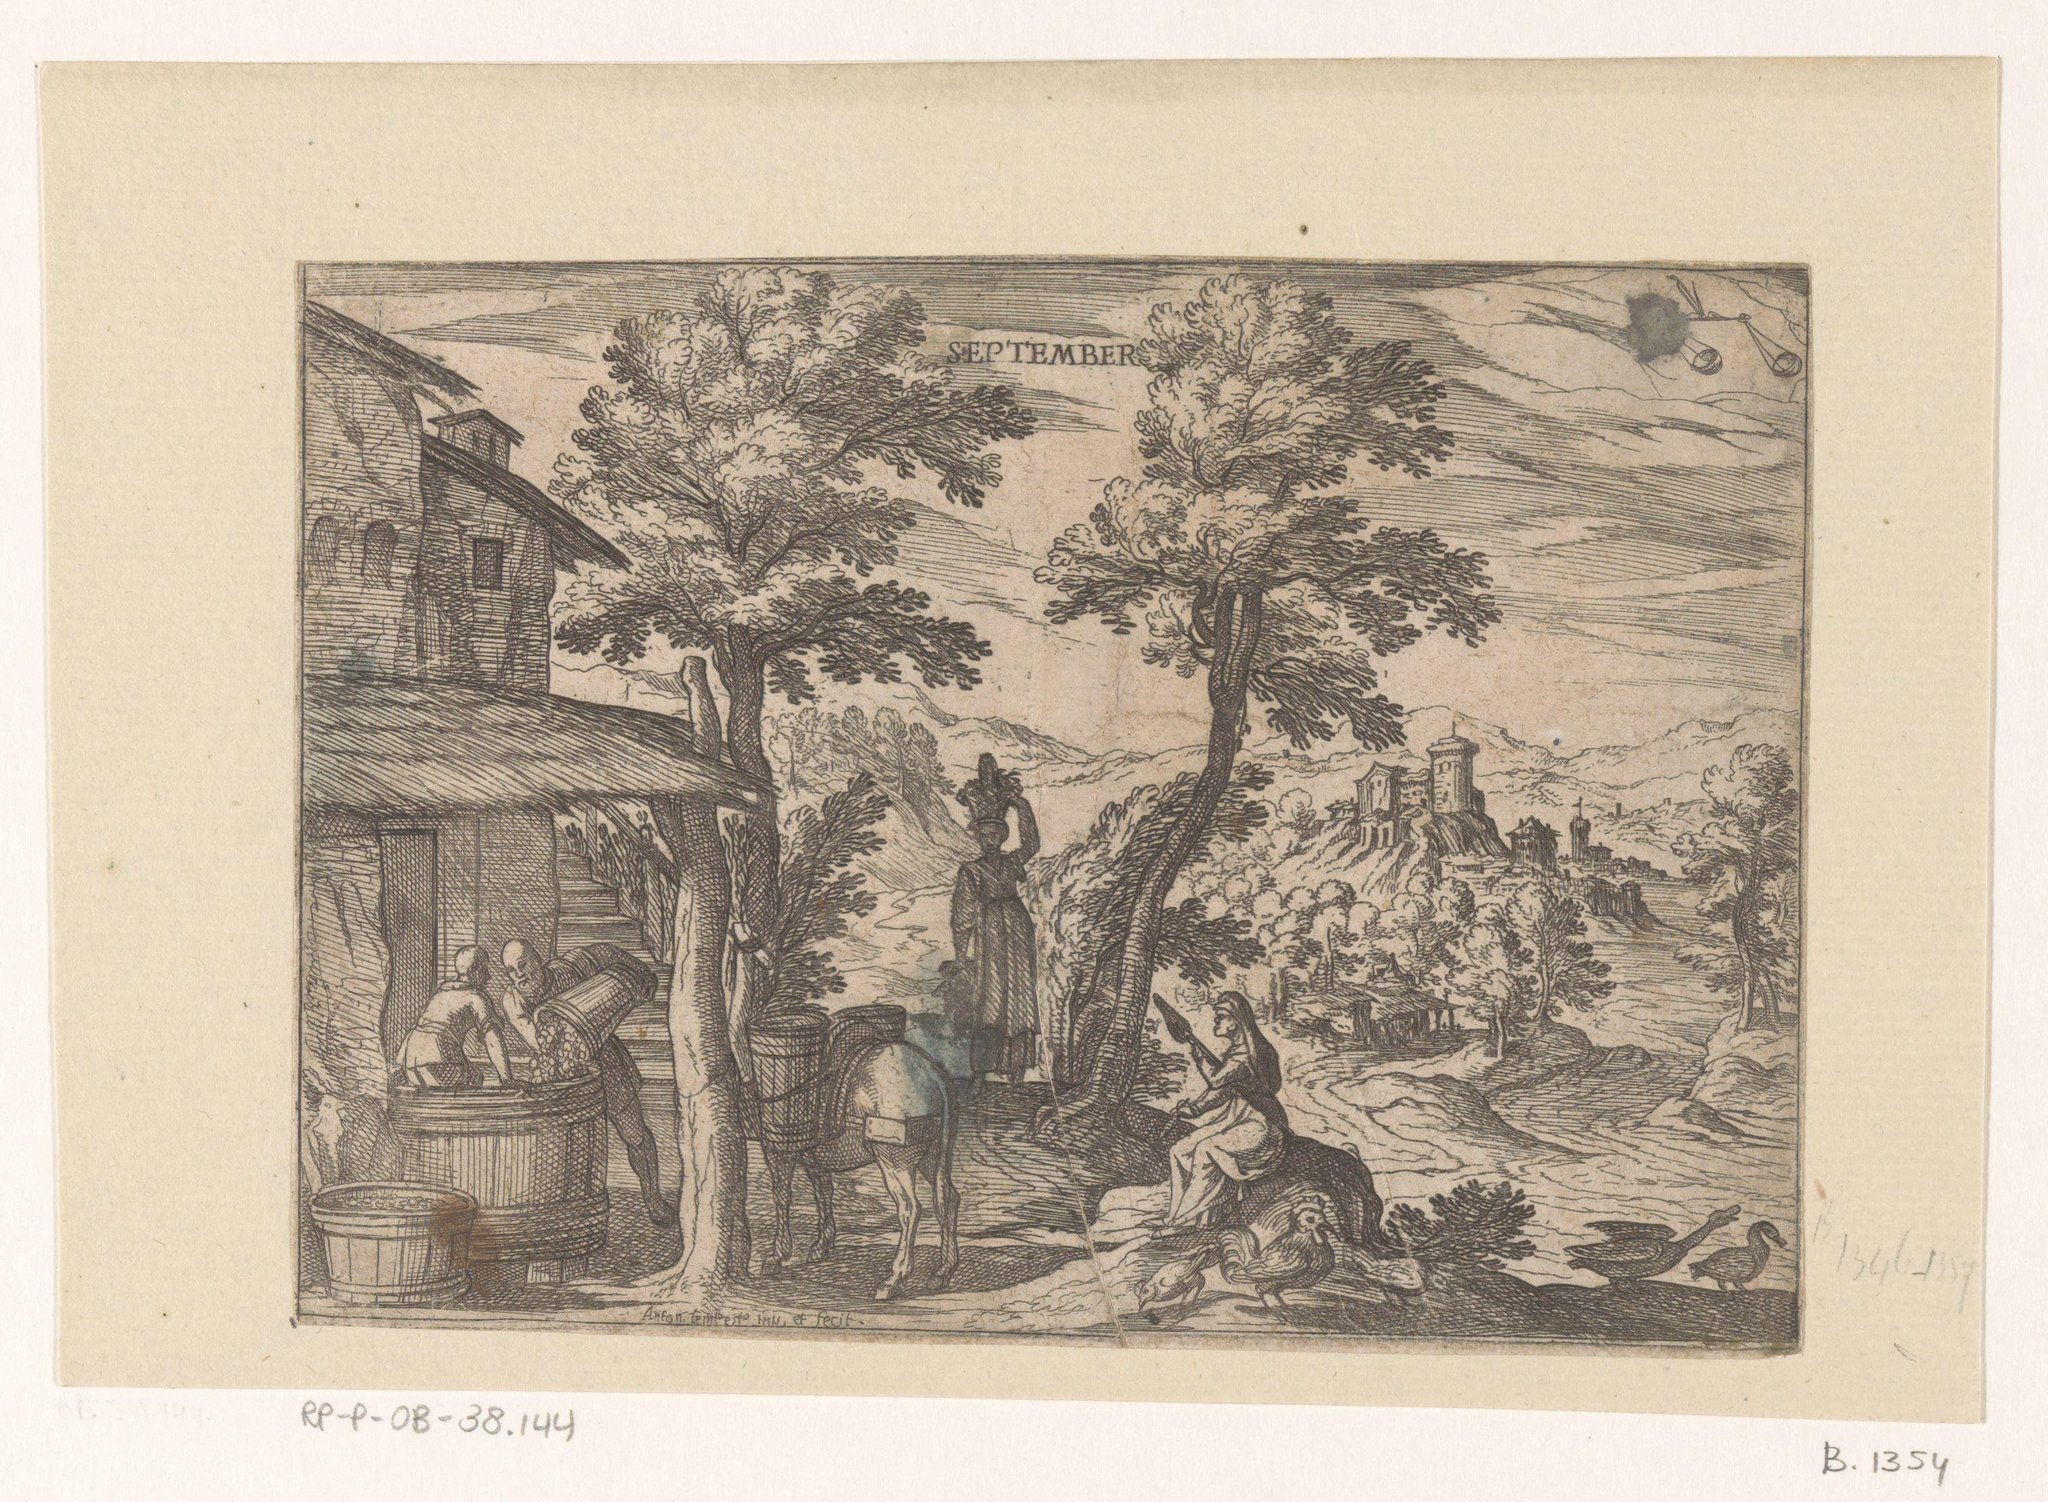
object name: print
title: September: wijn maken (weegschaal)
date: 1575-1613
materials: paper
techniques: etching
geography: italy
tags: landscape symbolizing september, wine production, spindle, libra (zodiacal sign of september)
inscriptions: collector's mark: Lugt 240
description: Landschap dat de maand september verbeeldt. Landschap met een spinnende vrouw en mannen die wijn maken door druiven te persen met hun voeten. Rechtsboven het symbool voor het sterrenbeeld weegschaal.